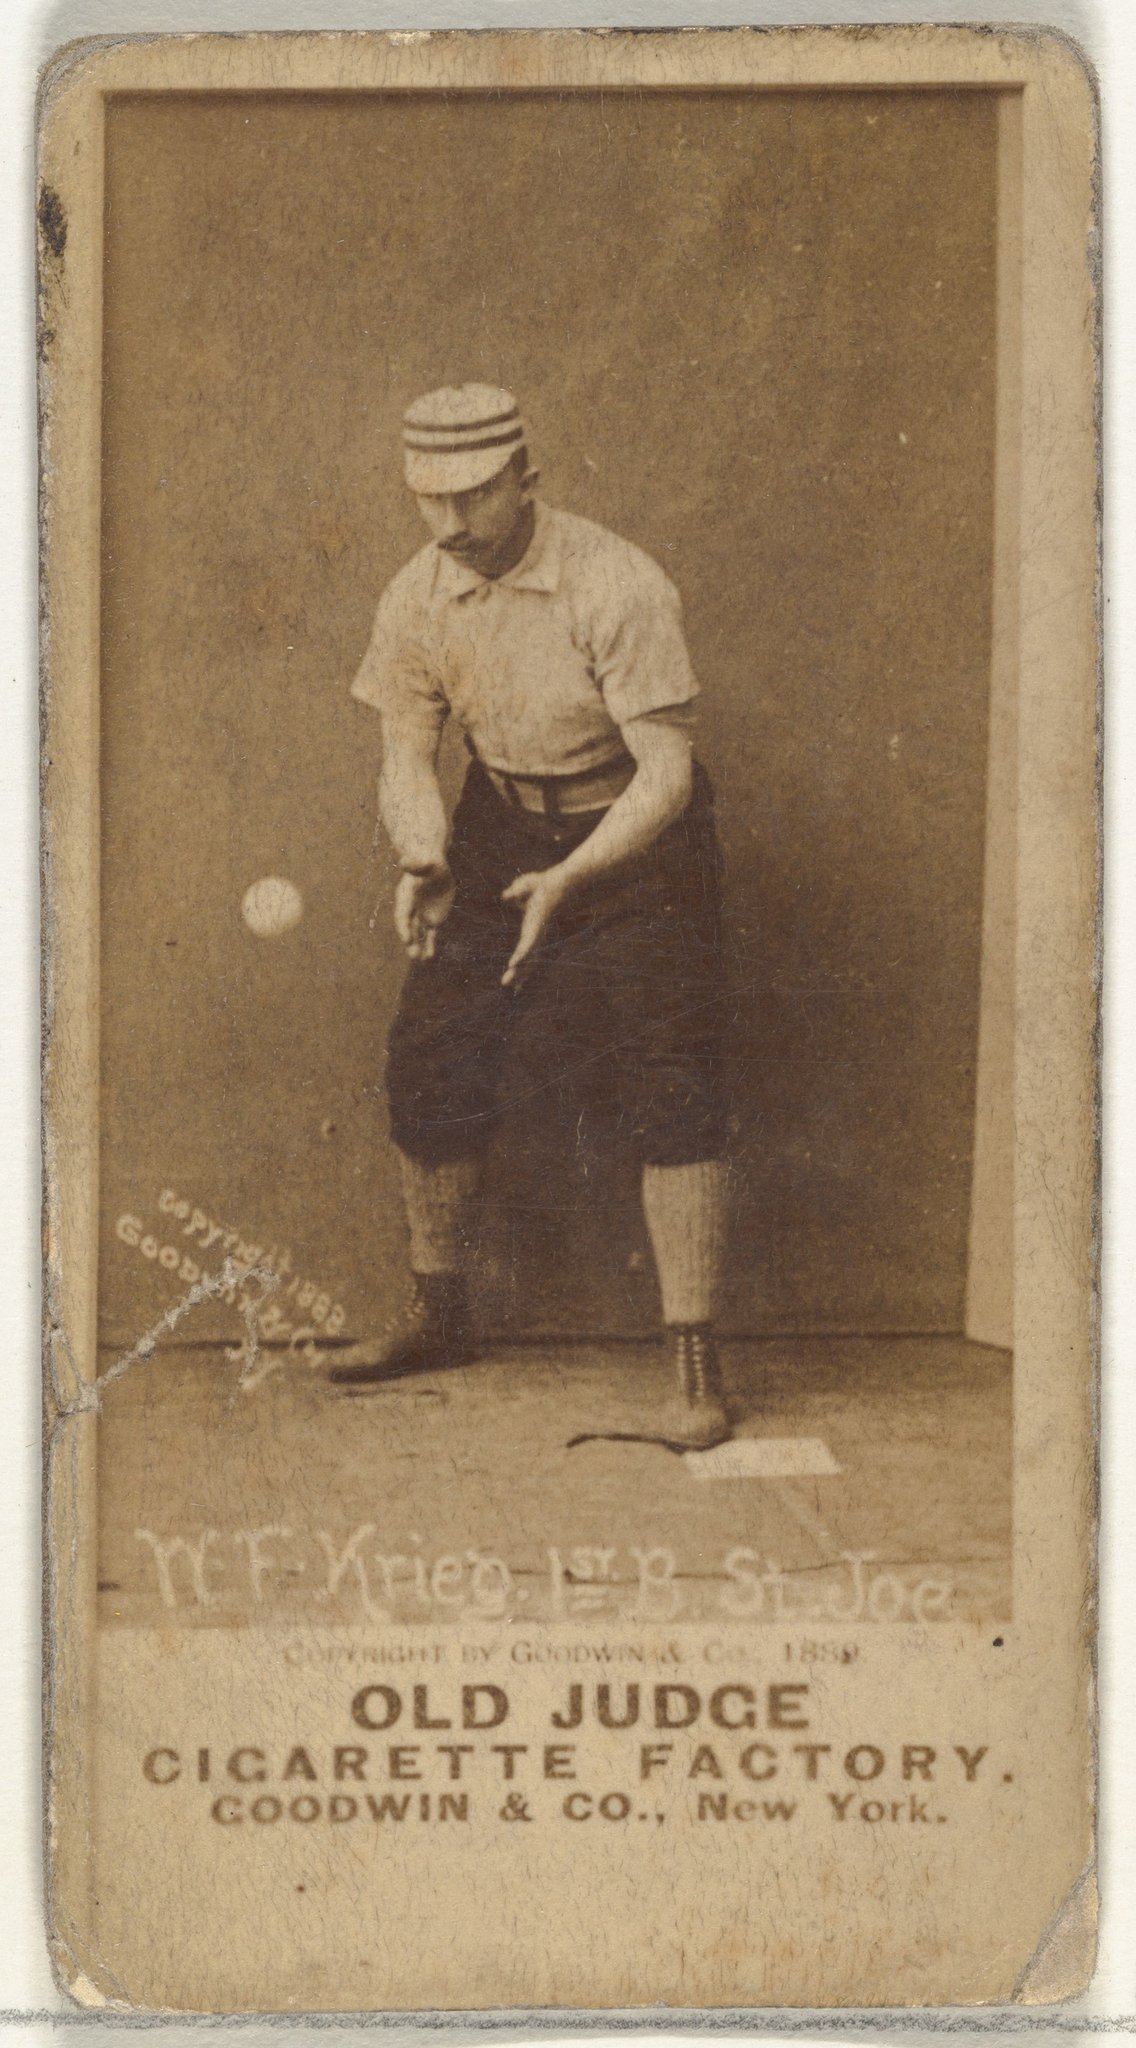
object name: baseball card, photograph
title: William Frederick "Bill" Krieg, 1st Base, St. Joseph Clay Eaters, from the Old Judge series (N172) for Old Judge Cigarettes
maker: goodwin & company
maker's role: publisher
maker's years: 1850-1950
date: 1888-1889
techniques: albumen silver print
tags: men,portraits,baseball,athletes